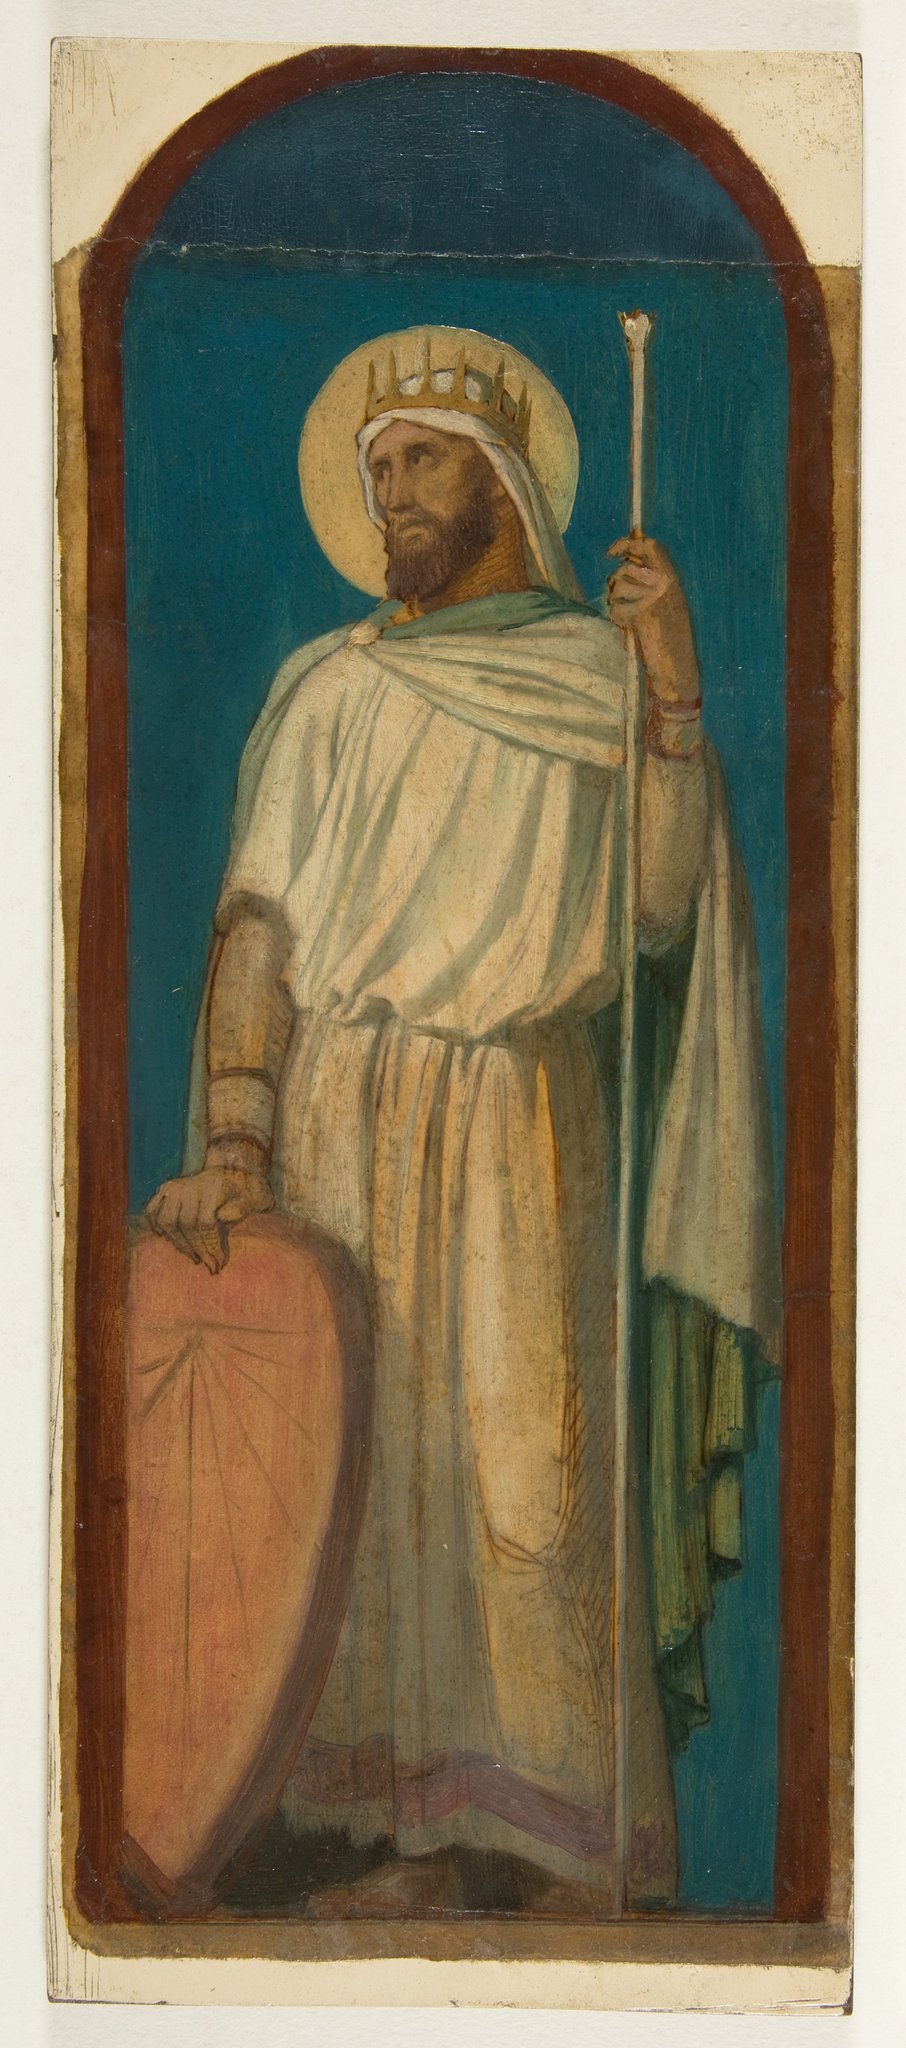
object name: drawing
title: Hezekiah, King of Judah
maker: hippolyte flandrin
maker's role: artist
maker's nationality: french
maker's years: 1809-1864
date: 1856-1863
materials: ink, oil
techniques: pen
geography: france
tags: shields,kings